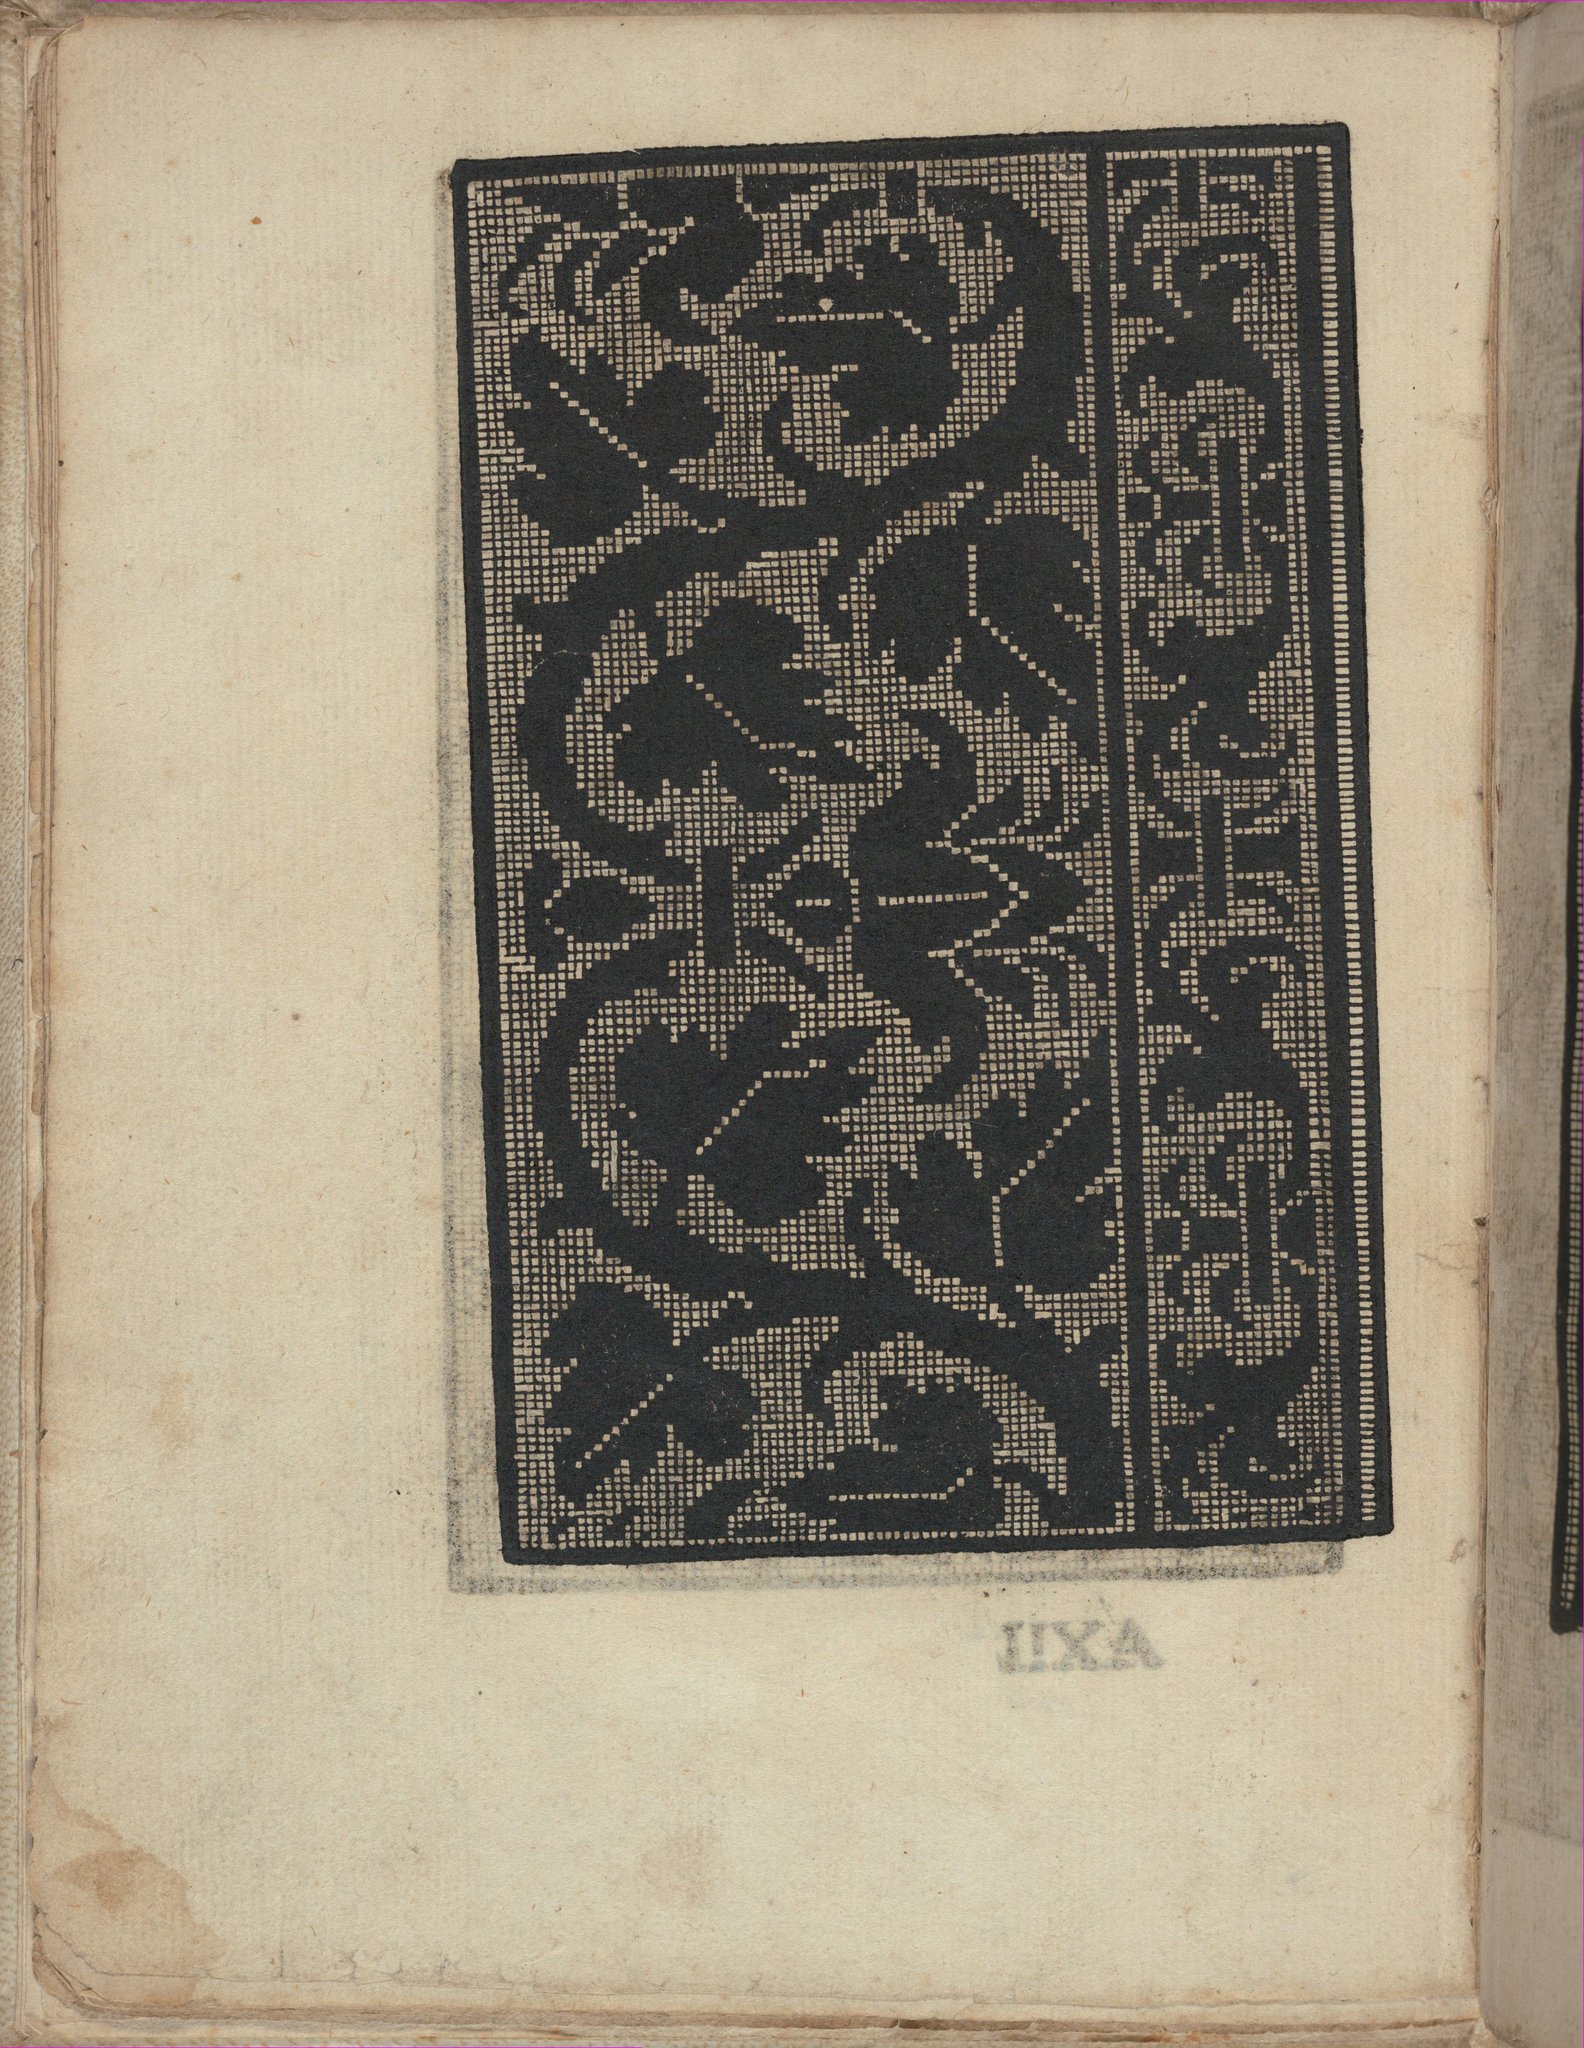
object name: book print ornament architecture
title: Esemplario di Lauori..., page 7 (verso)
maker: giovanni andrea vavassore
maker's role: publisher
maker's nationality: italian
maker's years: 1530-1573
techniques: woodcut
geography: venice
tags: ornament